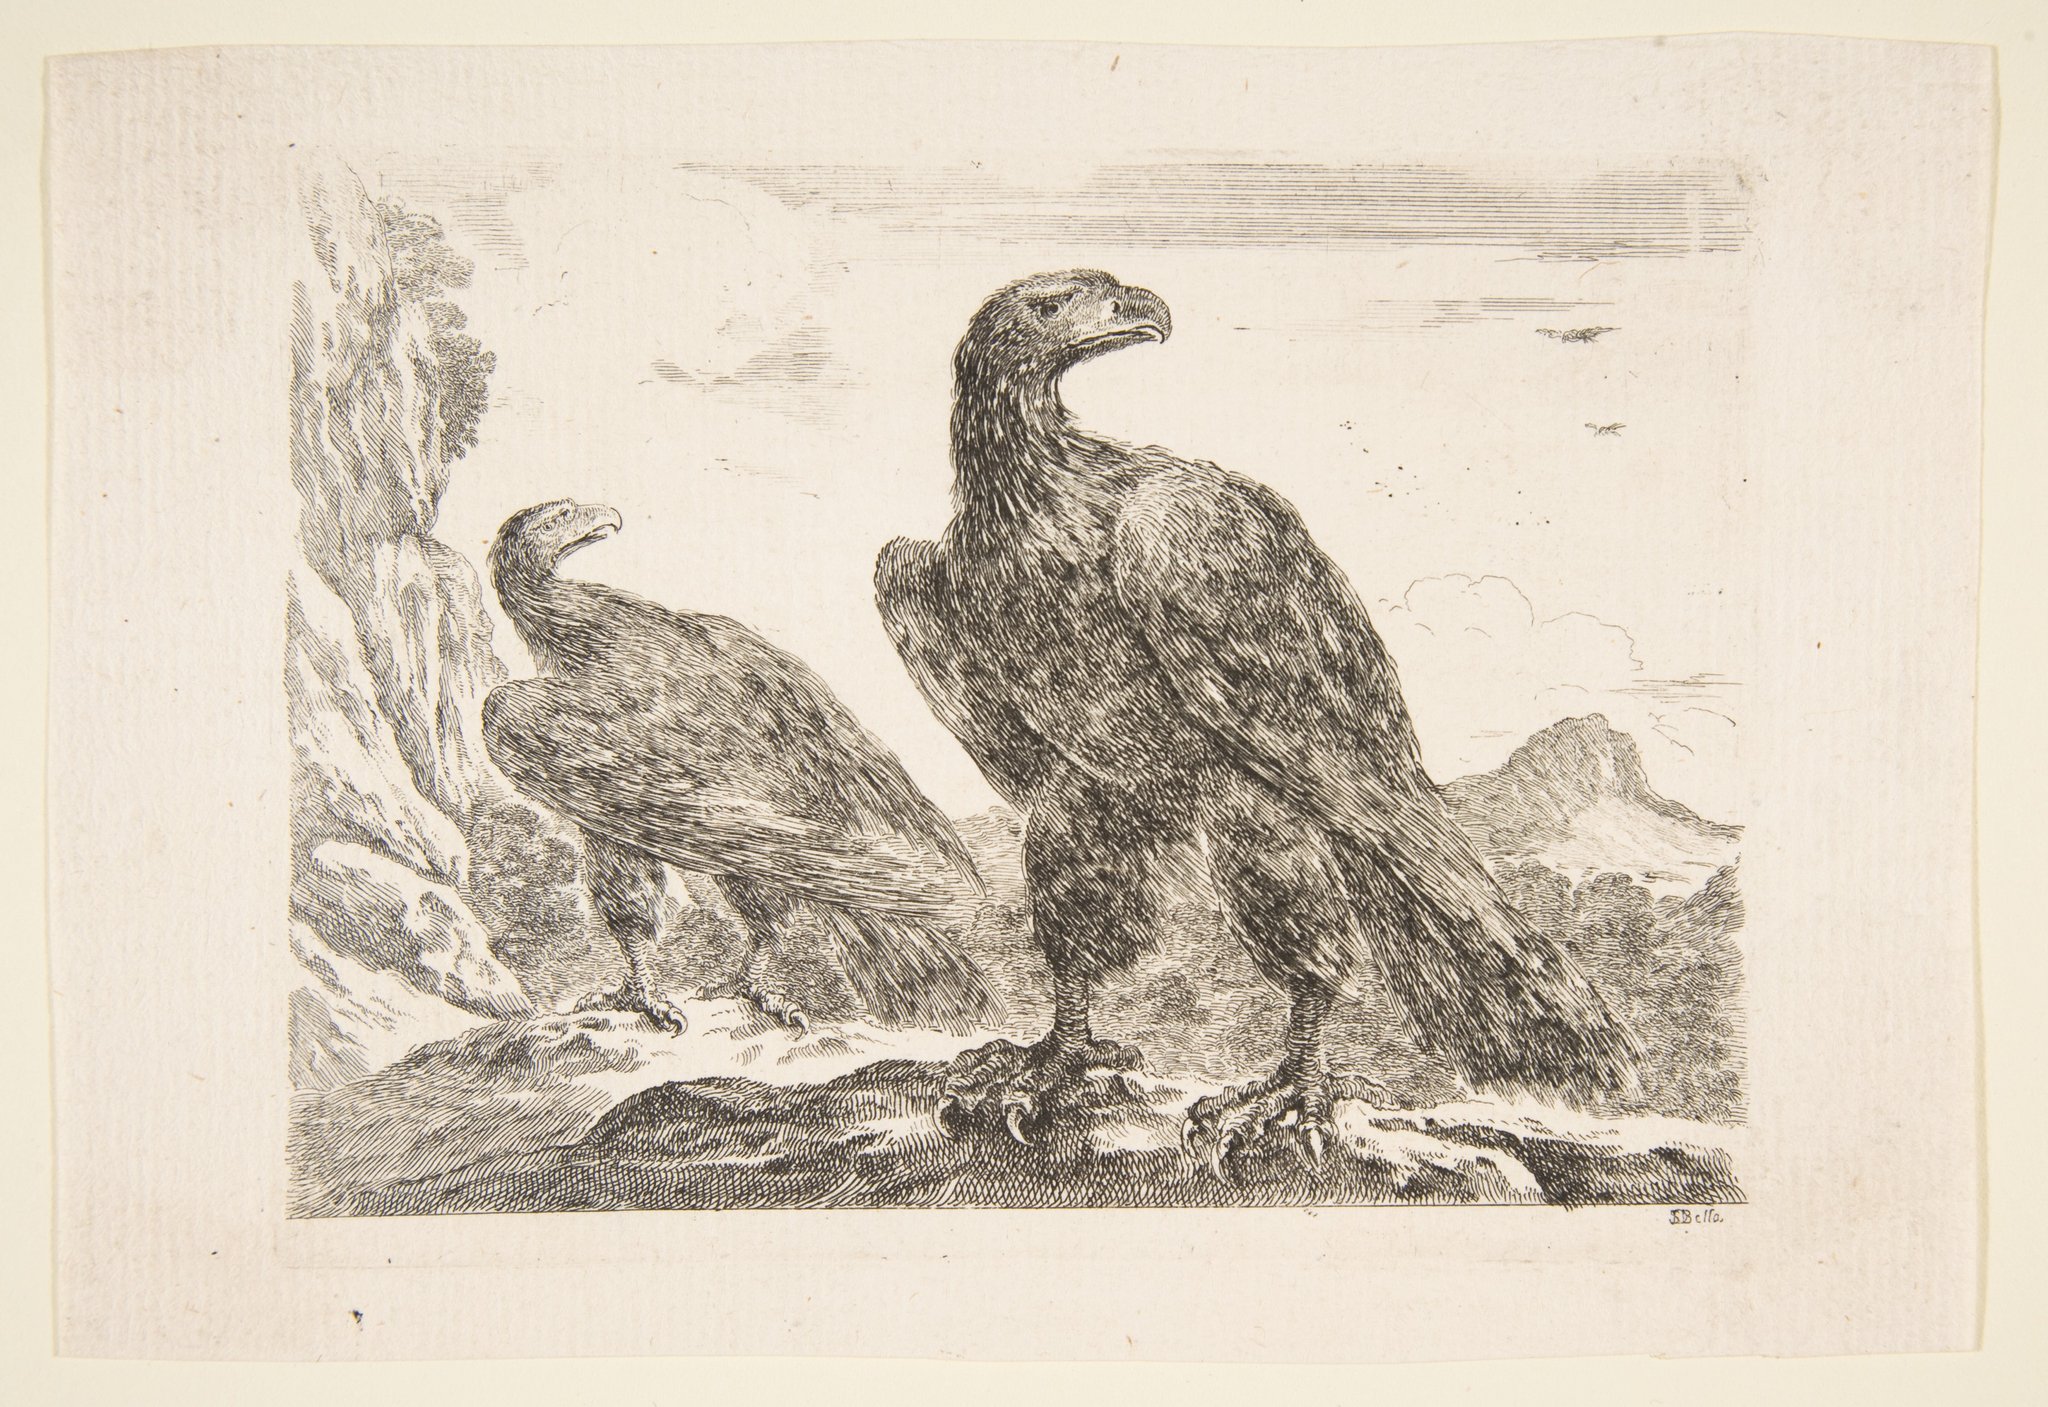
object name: print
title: Two eagles, from 'Eagles' (Les aigles)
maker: stefano della bella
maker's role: artist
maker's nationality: italian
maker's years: 1610-1664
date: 1651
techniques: etching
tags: eagles